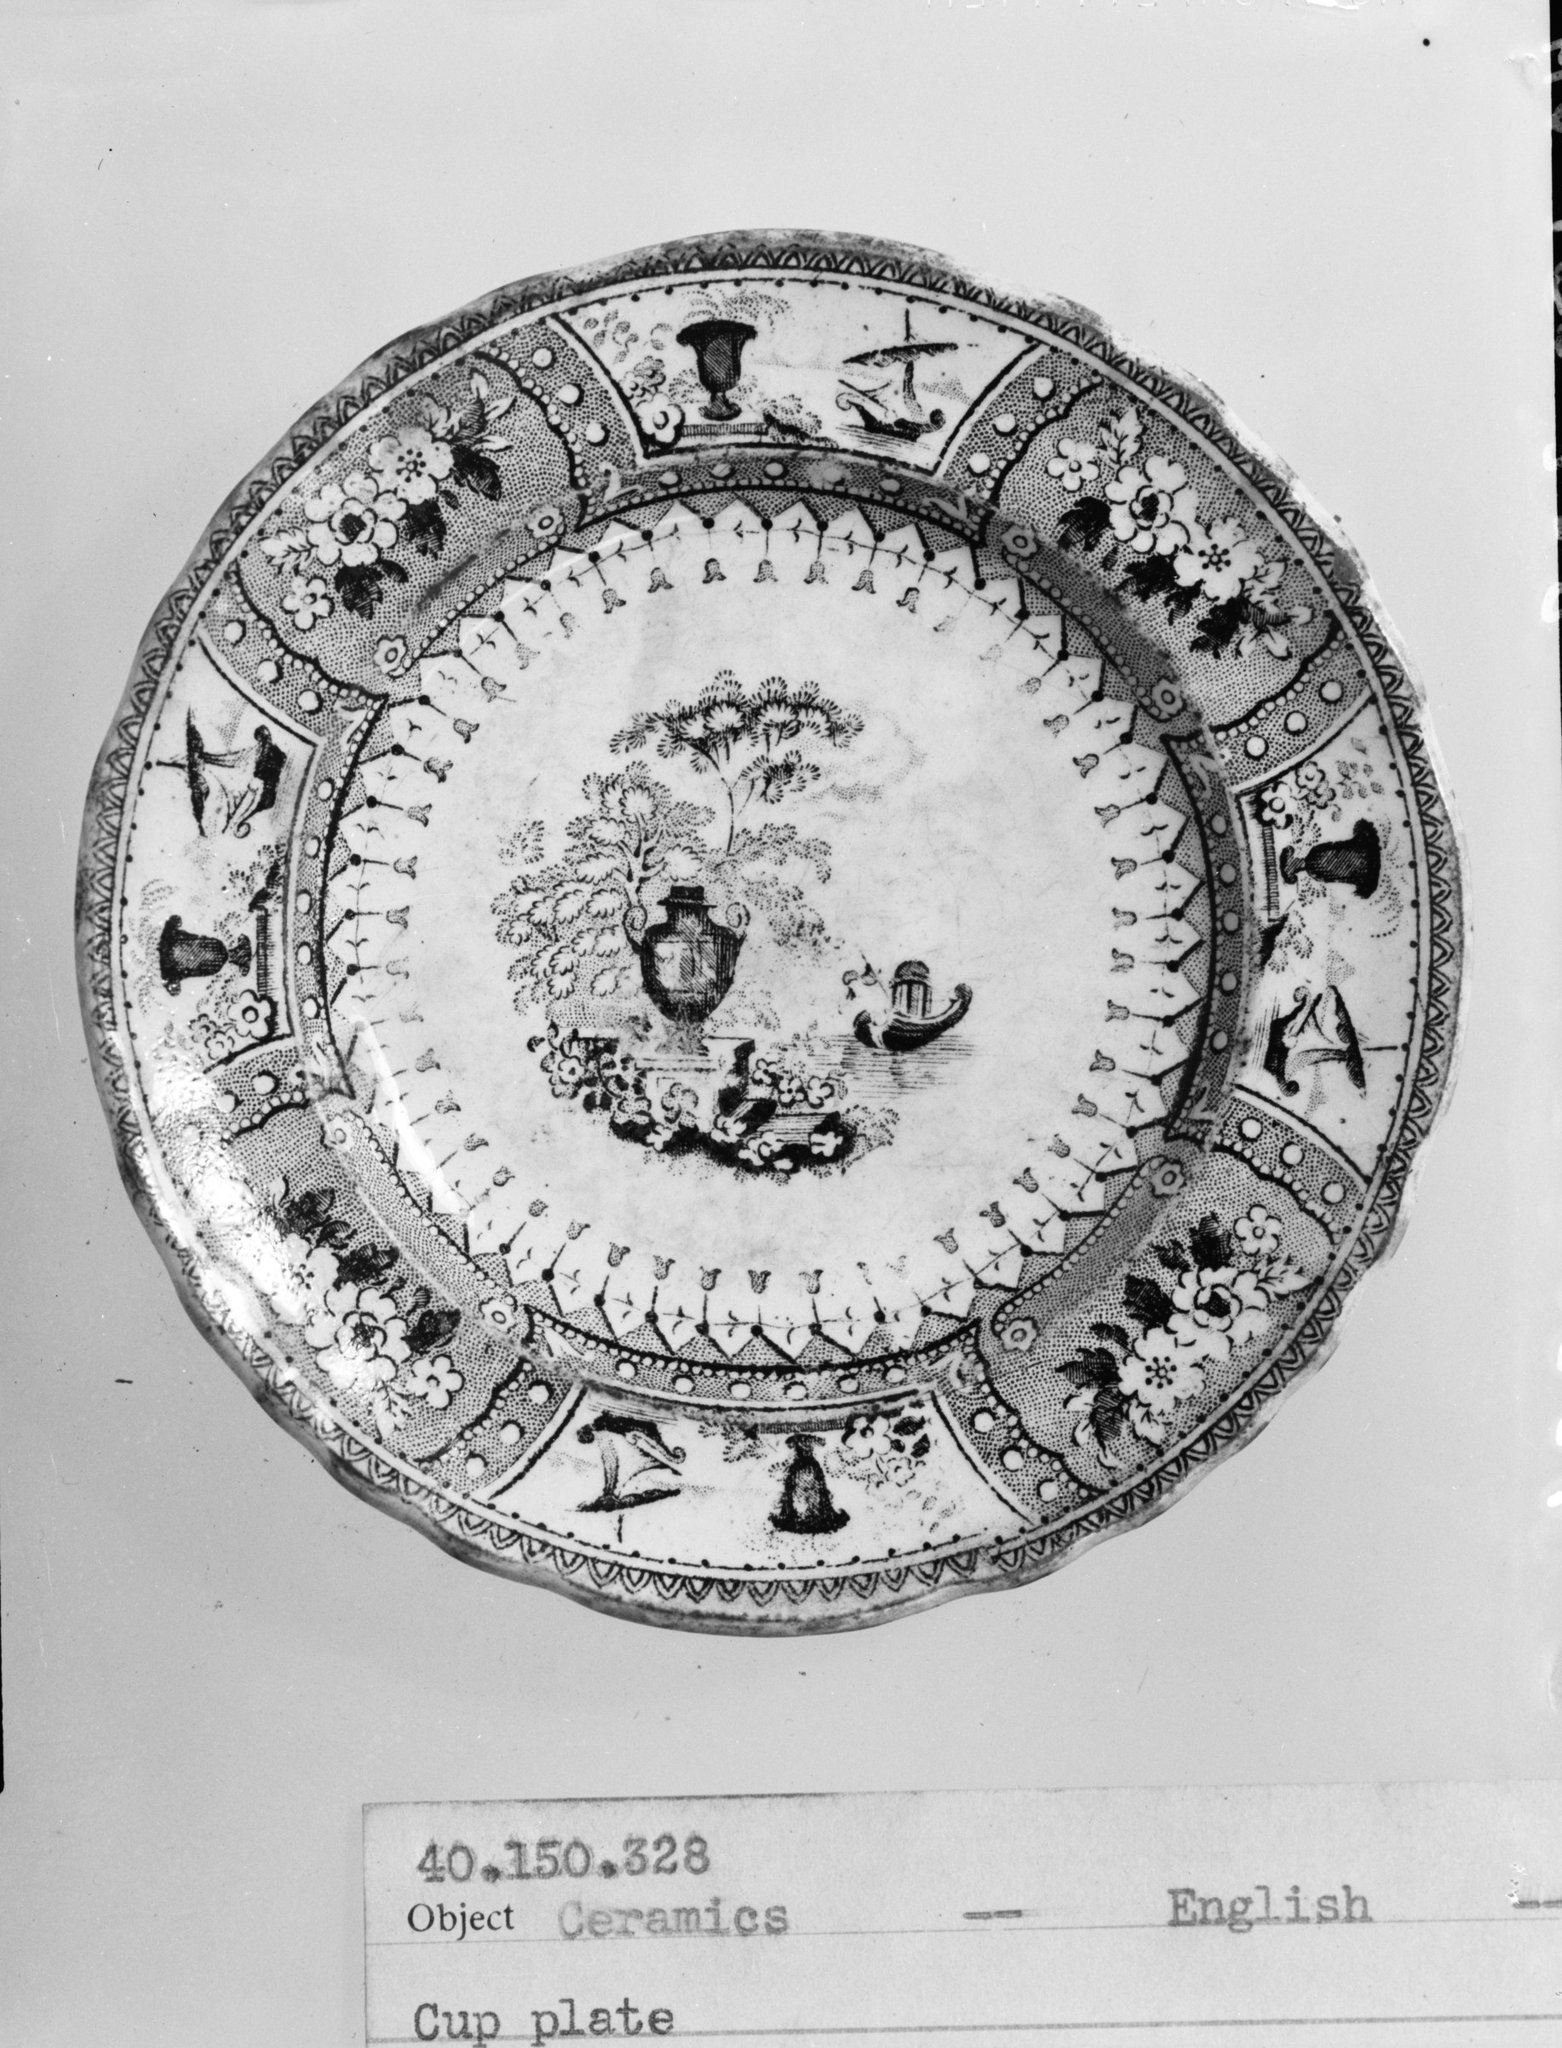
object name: plate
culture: british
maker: thomas mayer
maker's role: maker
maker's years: 1823-1838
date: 1826-1838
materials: earthenware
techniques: transfer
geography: england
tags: flowers